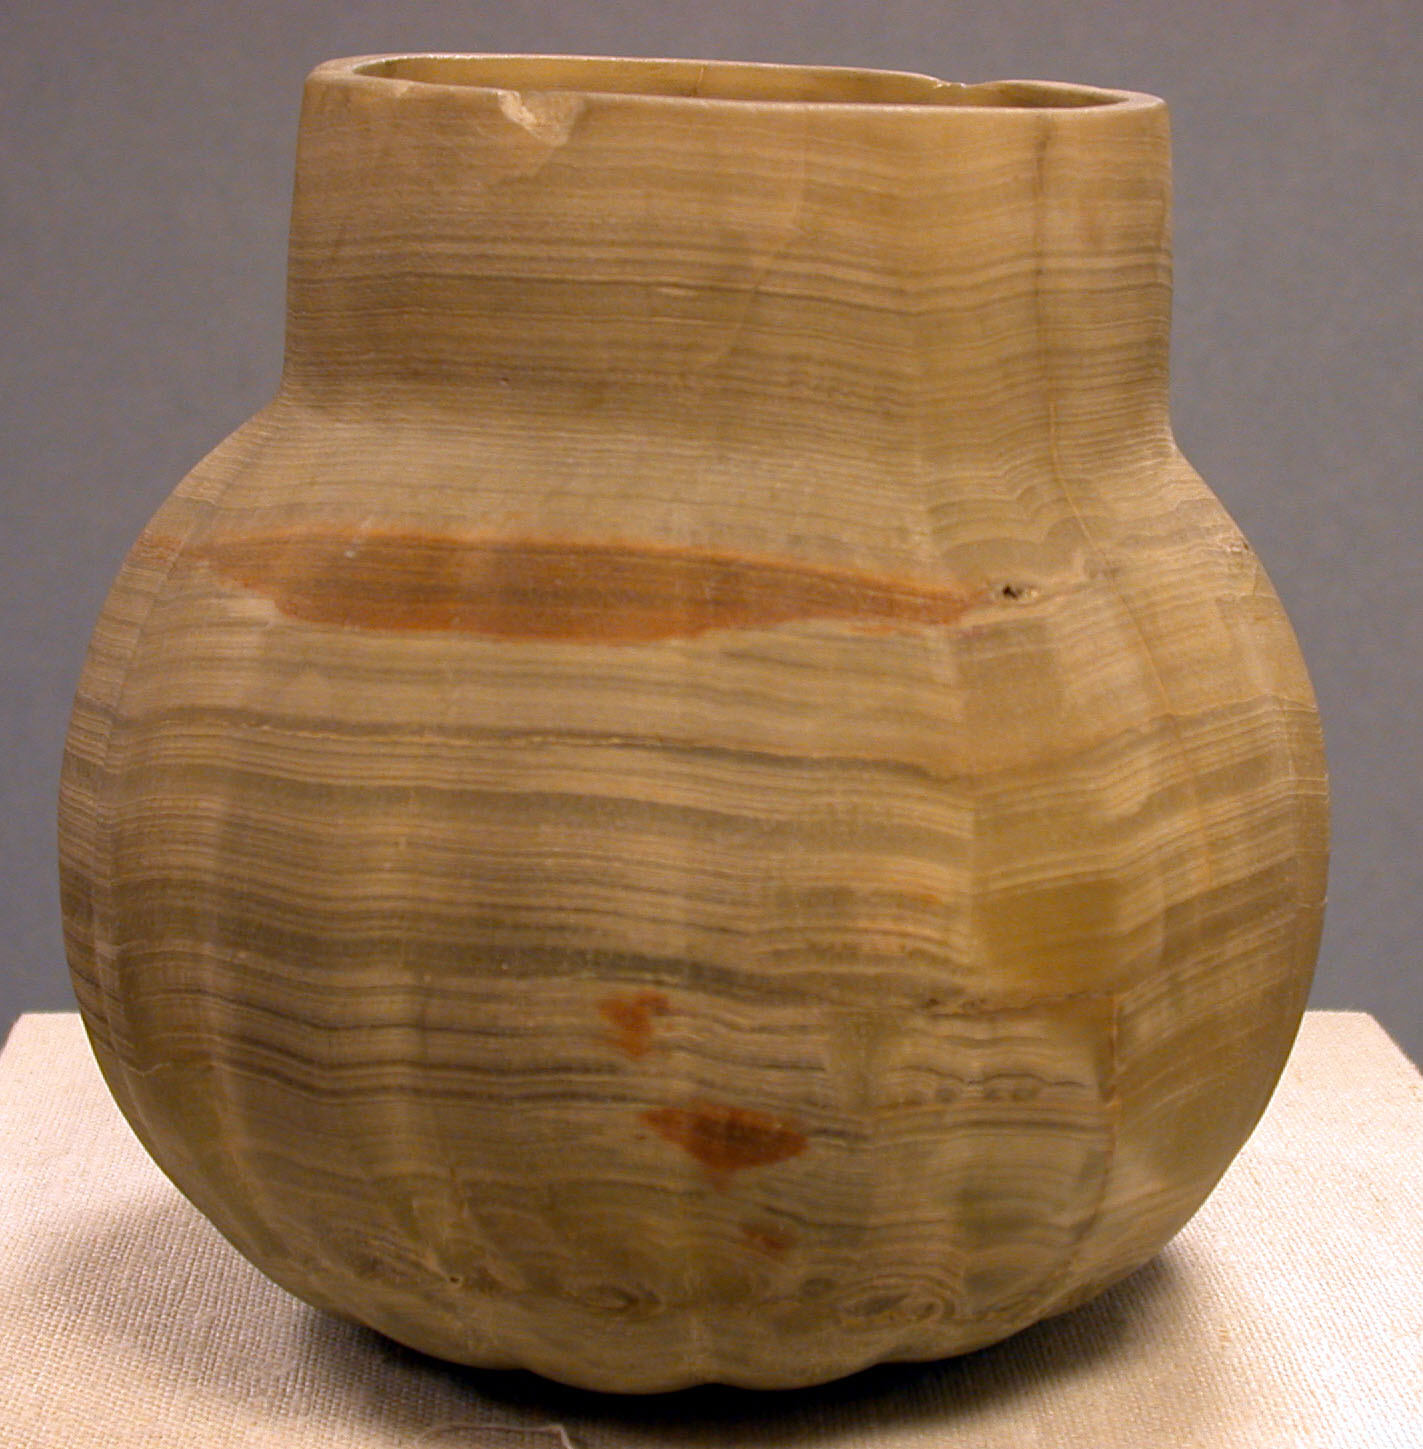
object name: vessel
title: Gadrooned Onyx Vessel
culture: mexican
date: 1501-1600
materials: marble, onyx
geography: mexico